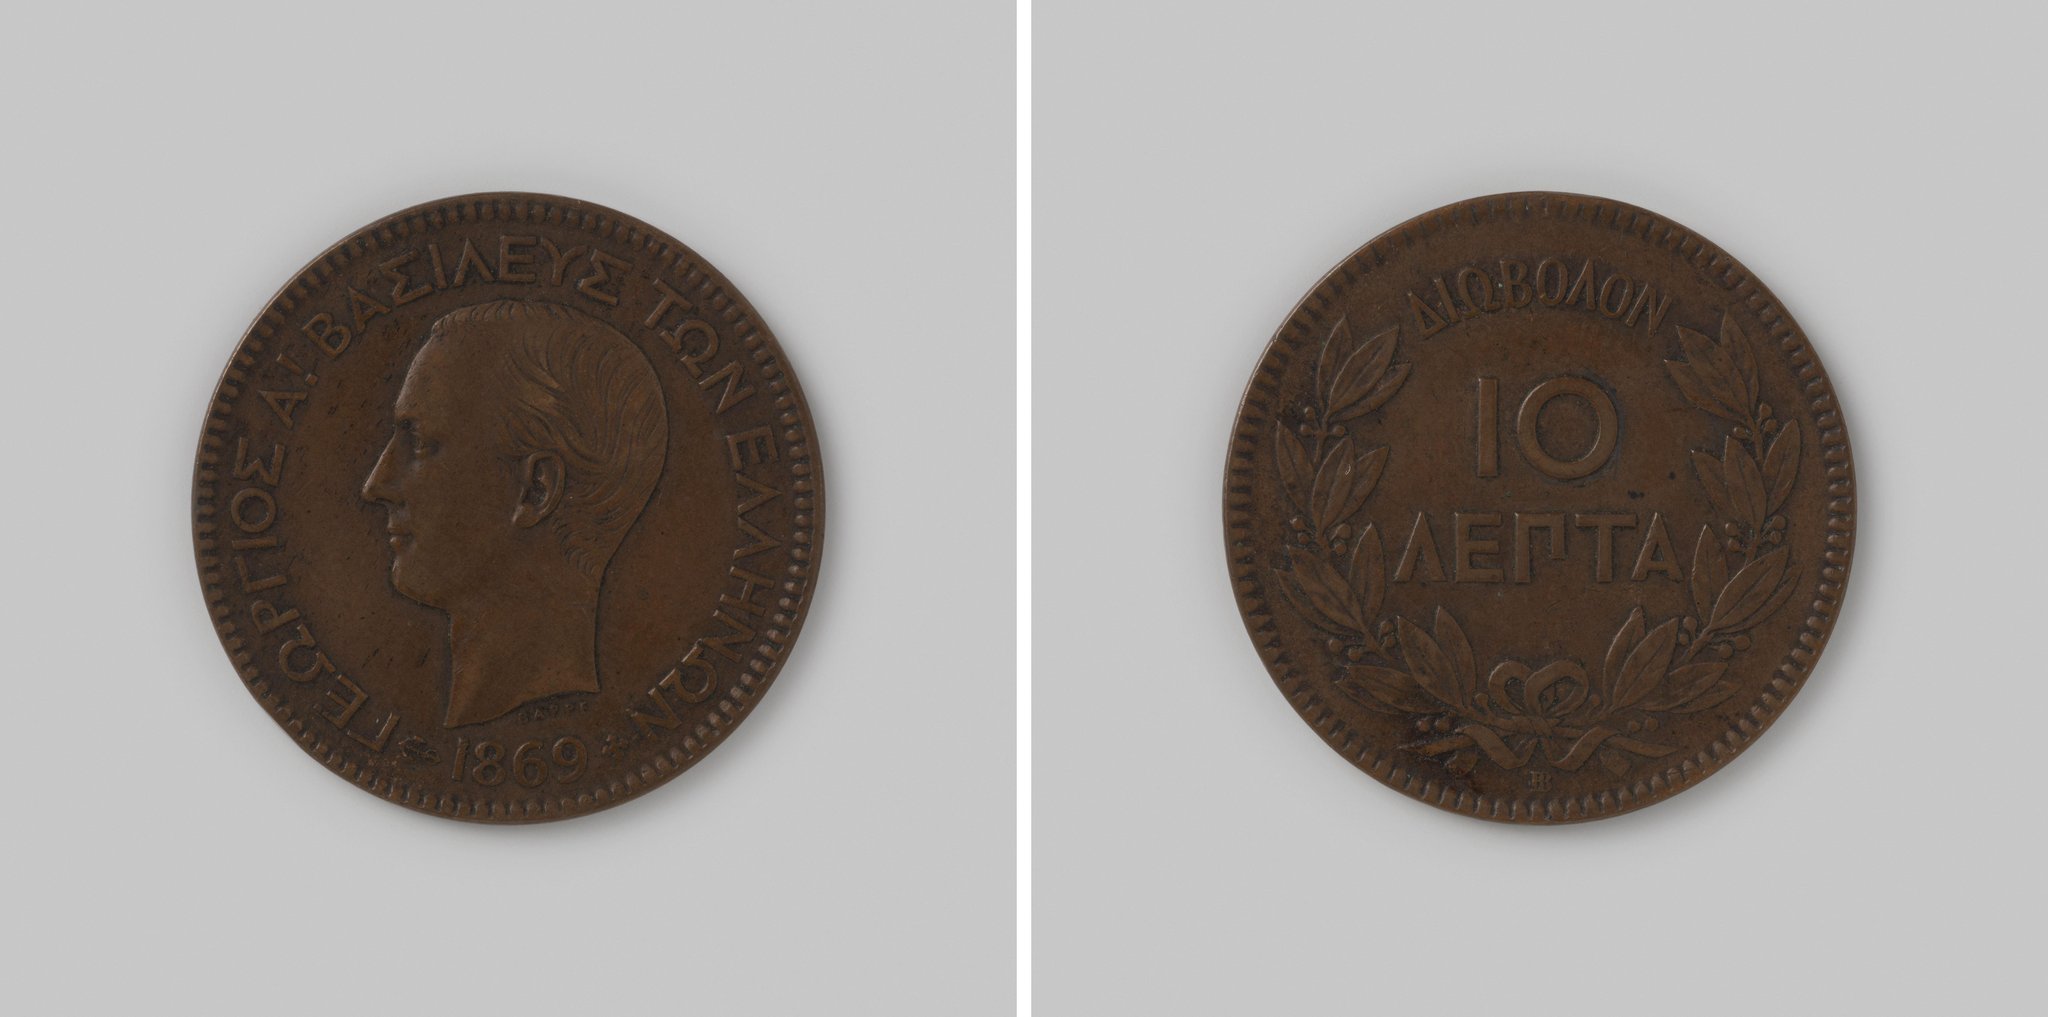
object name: coin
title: Griekenland, koning Georgios I, diobolon of 10 lepta, 1869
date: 1869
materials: copper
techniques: striking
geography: straatsburg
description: Koperen munt. Voorzijde: hoofd van de koning naar links. Daaronder jaartal. Keerzijde: tussen twee met strik samengebonden takken waarde-aanduidingen in twee regels. Onder strik letters BB in ligatuur [=Straatsburg]. Gladde rand.